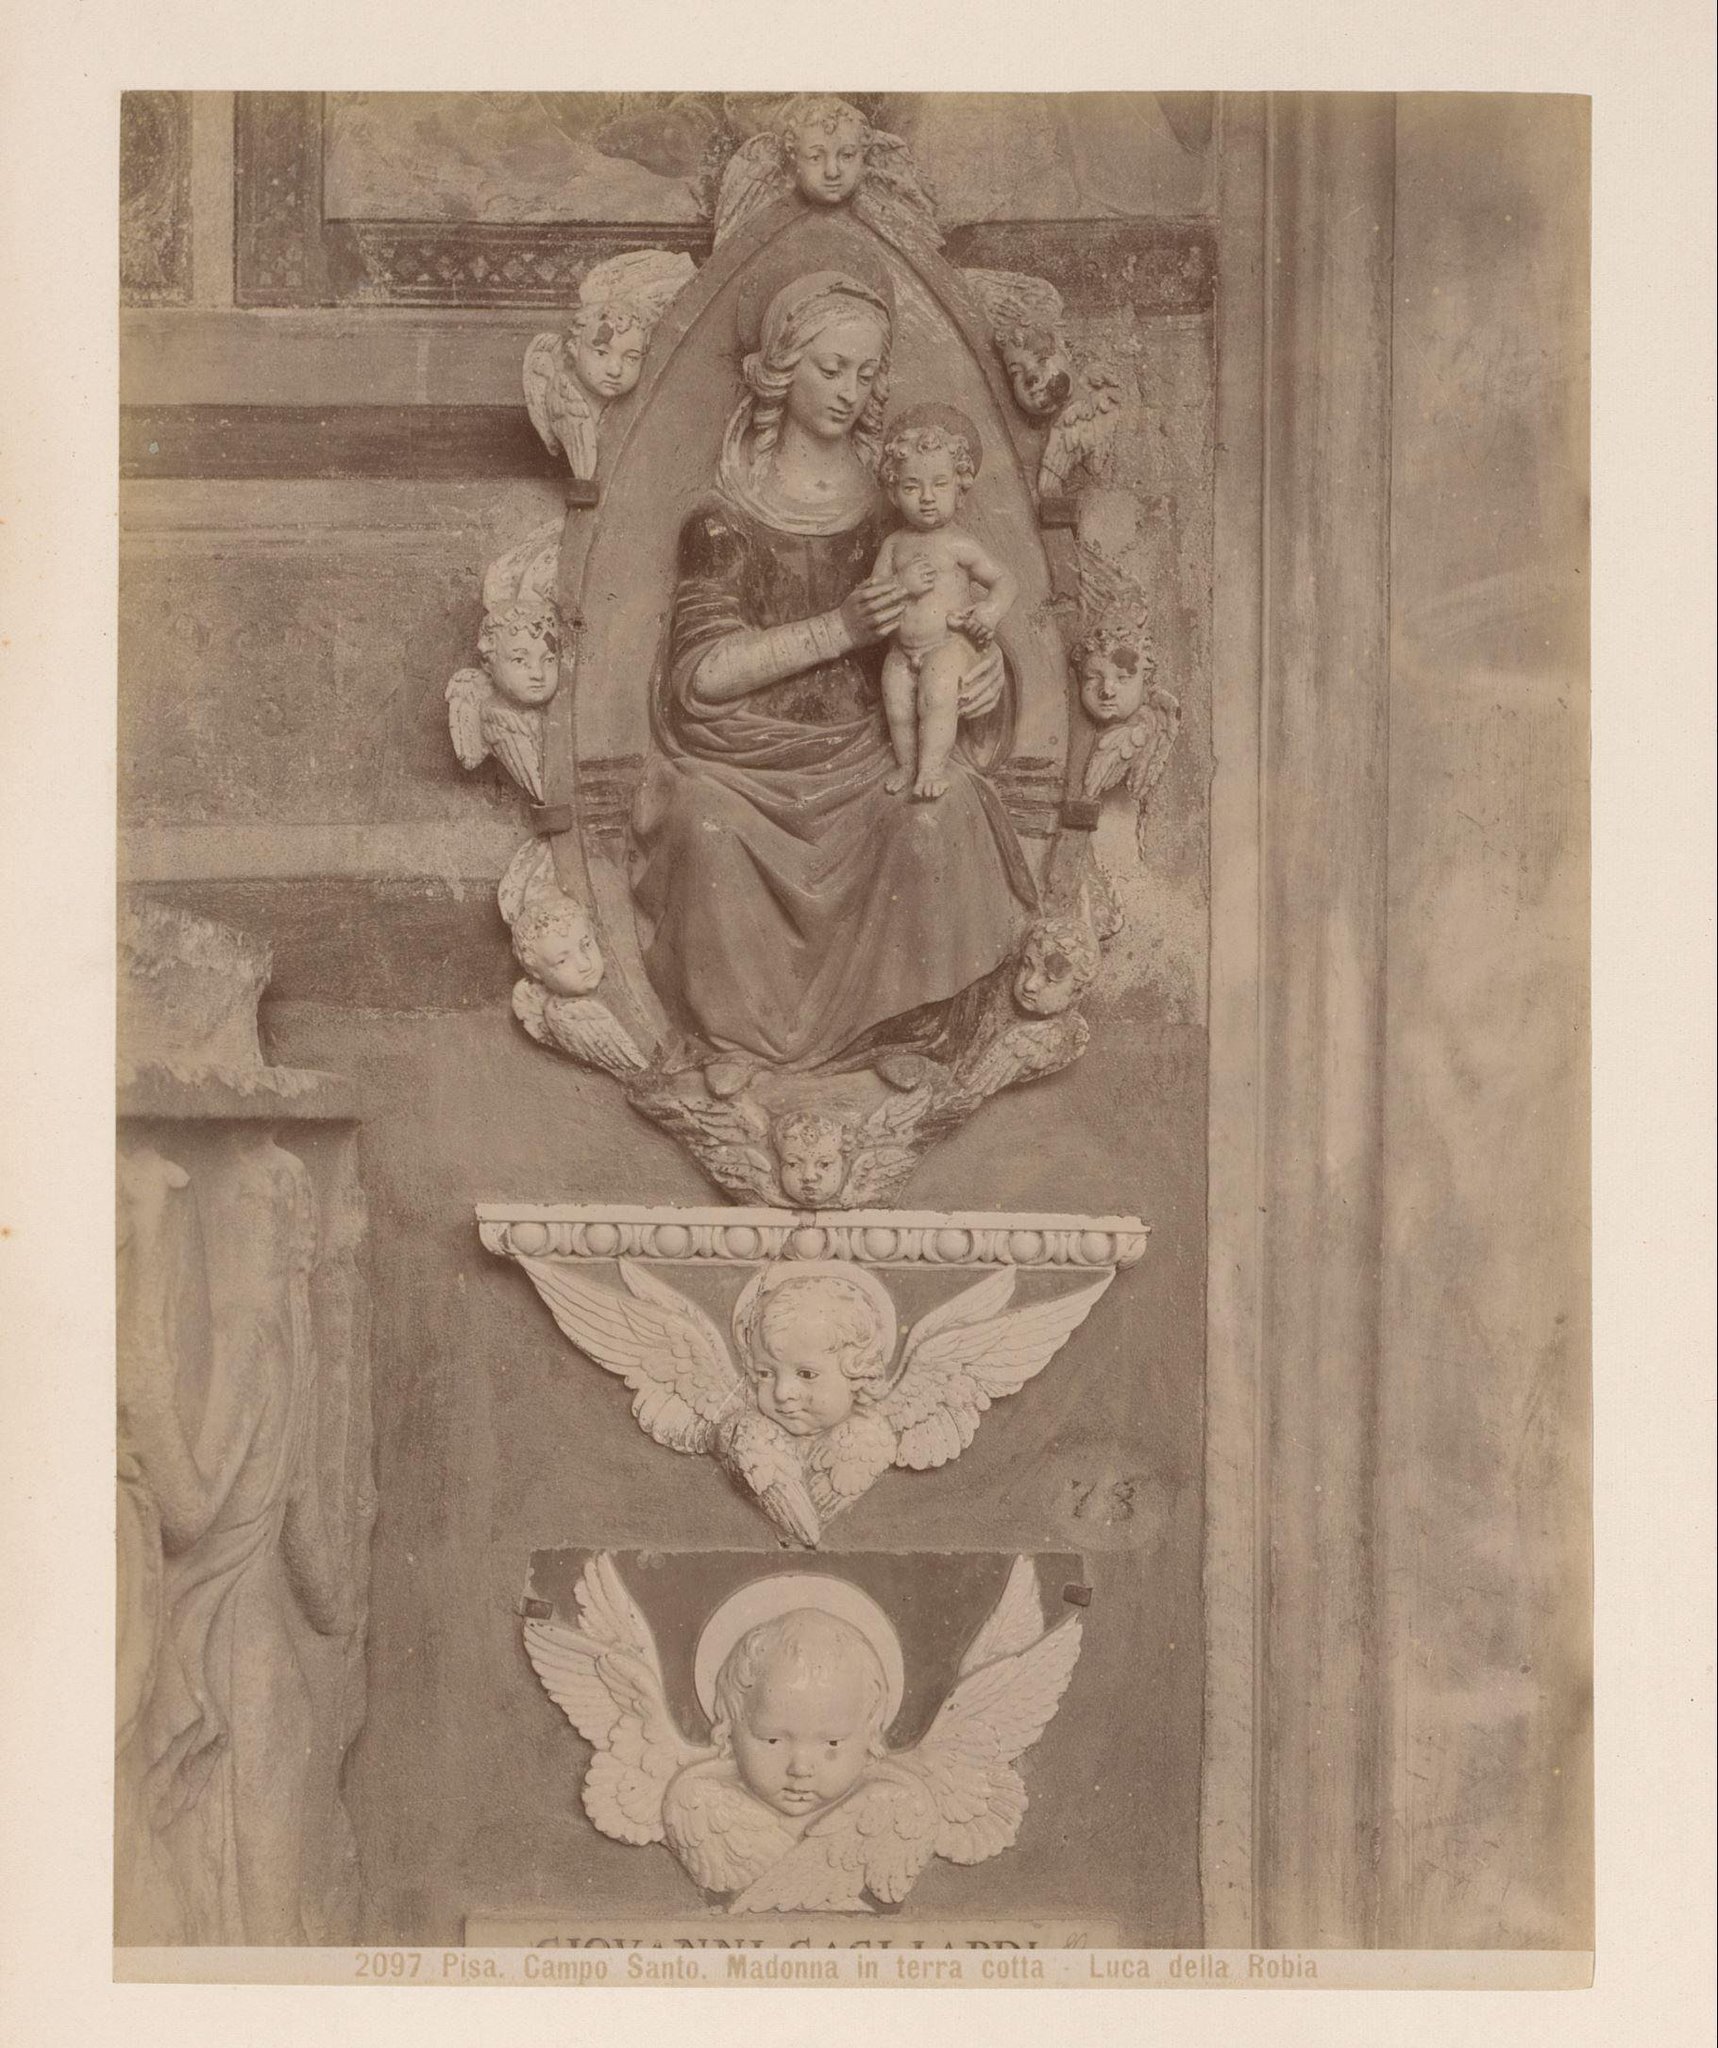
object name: photograph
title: Sculptuur van Madonna met kind uit terracotta naar Luca della Robbia in het Camposanto te Pisa, Italië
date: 1860-1881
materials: paper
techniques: albumen print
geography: pisa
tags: madonna: i.e. mary with the christ-child, piece of sculpture, reproduction of a piece of sculpture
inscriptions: number: ‘2097’